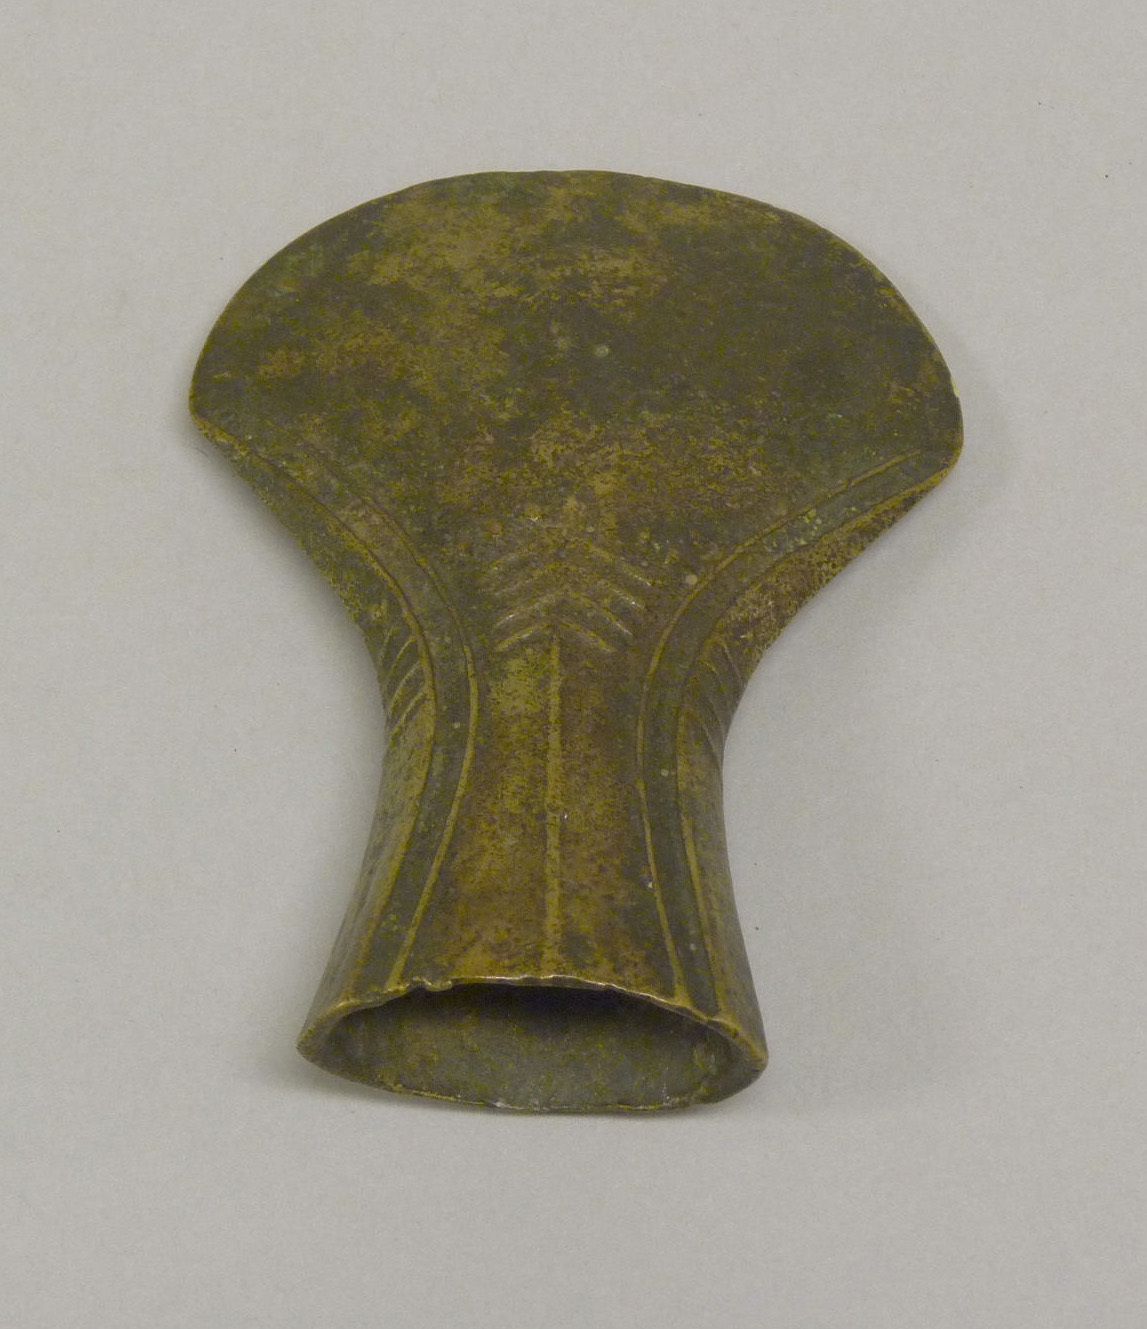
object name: hafted ax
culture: indonesian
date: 500 BCE-300 CE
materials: bronze